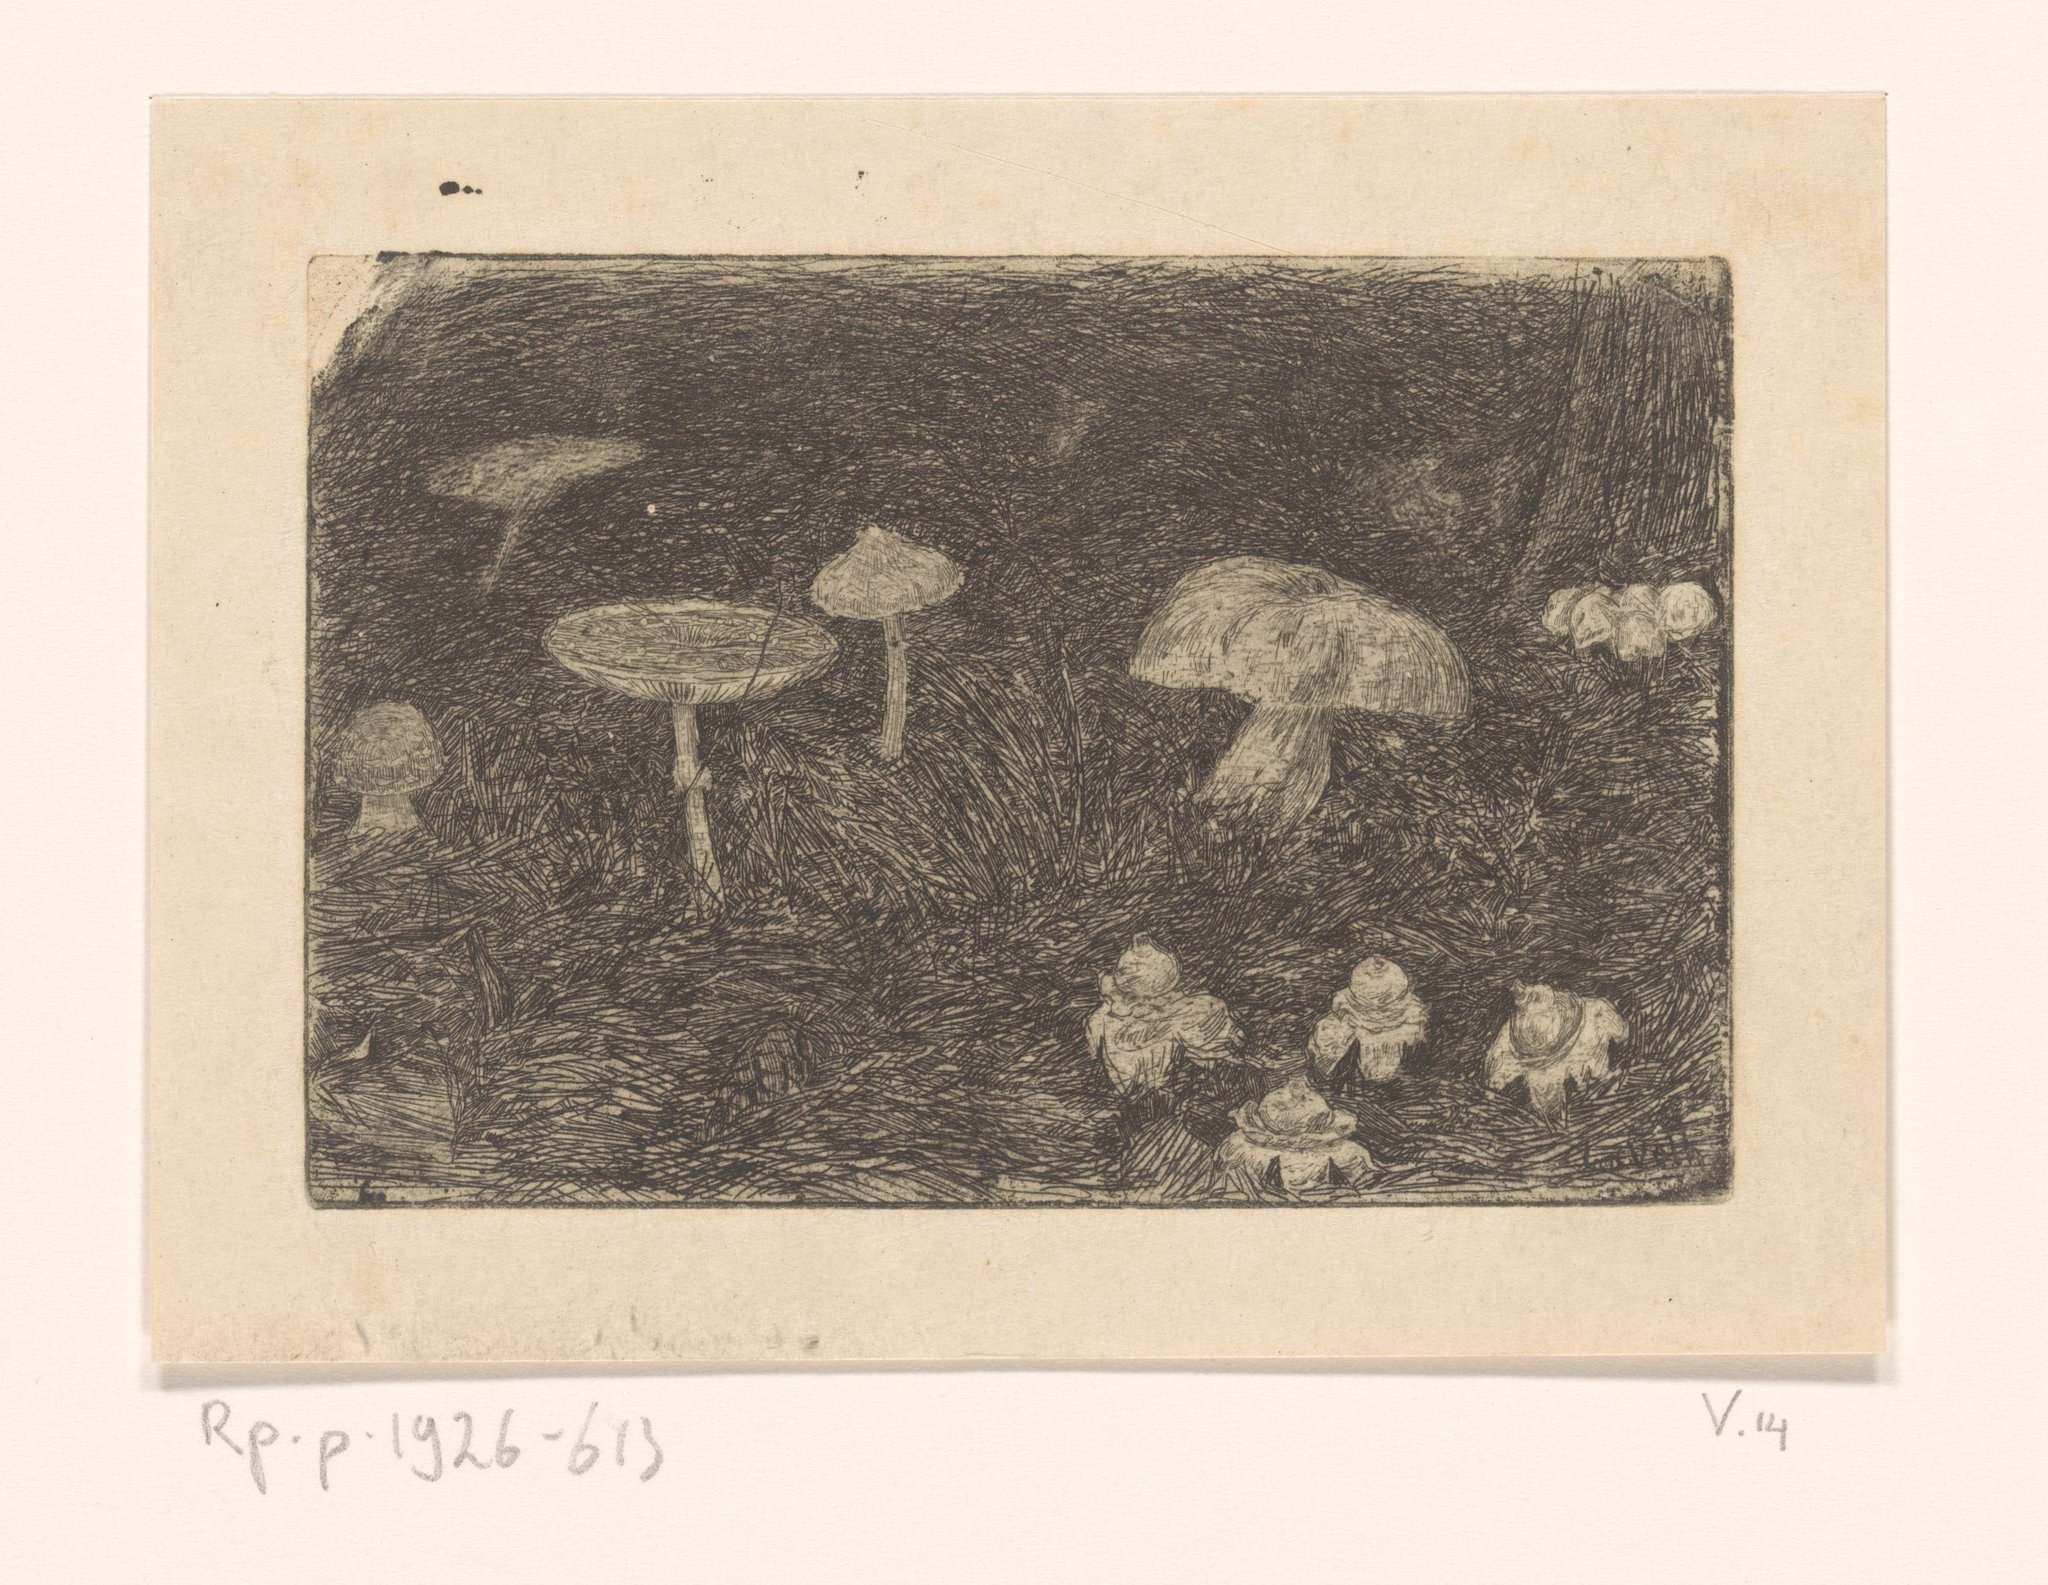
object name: print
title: Paddenstoelen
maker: jan veth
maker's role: designer, draughtsman, painter, print maker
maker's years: 1864-1925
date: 1886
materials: paper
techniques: etching, intaglio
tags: mushrooms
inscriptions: collector's mark: Lugt 2228